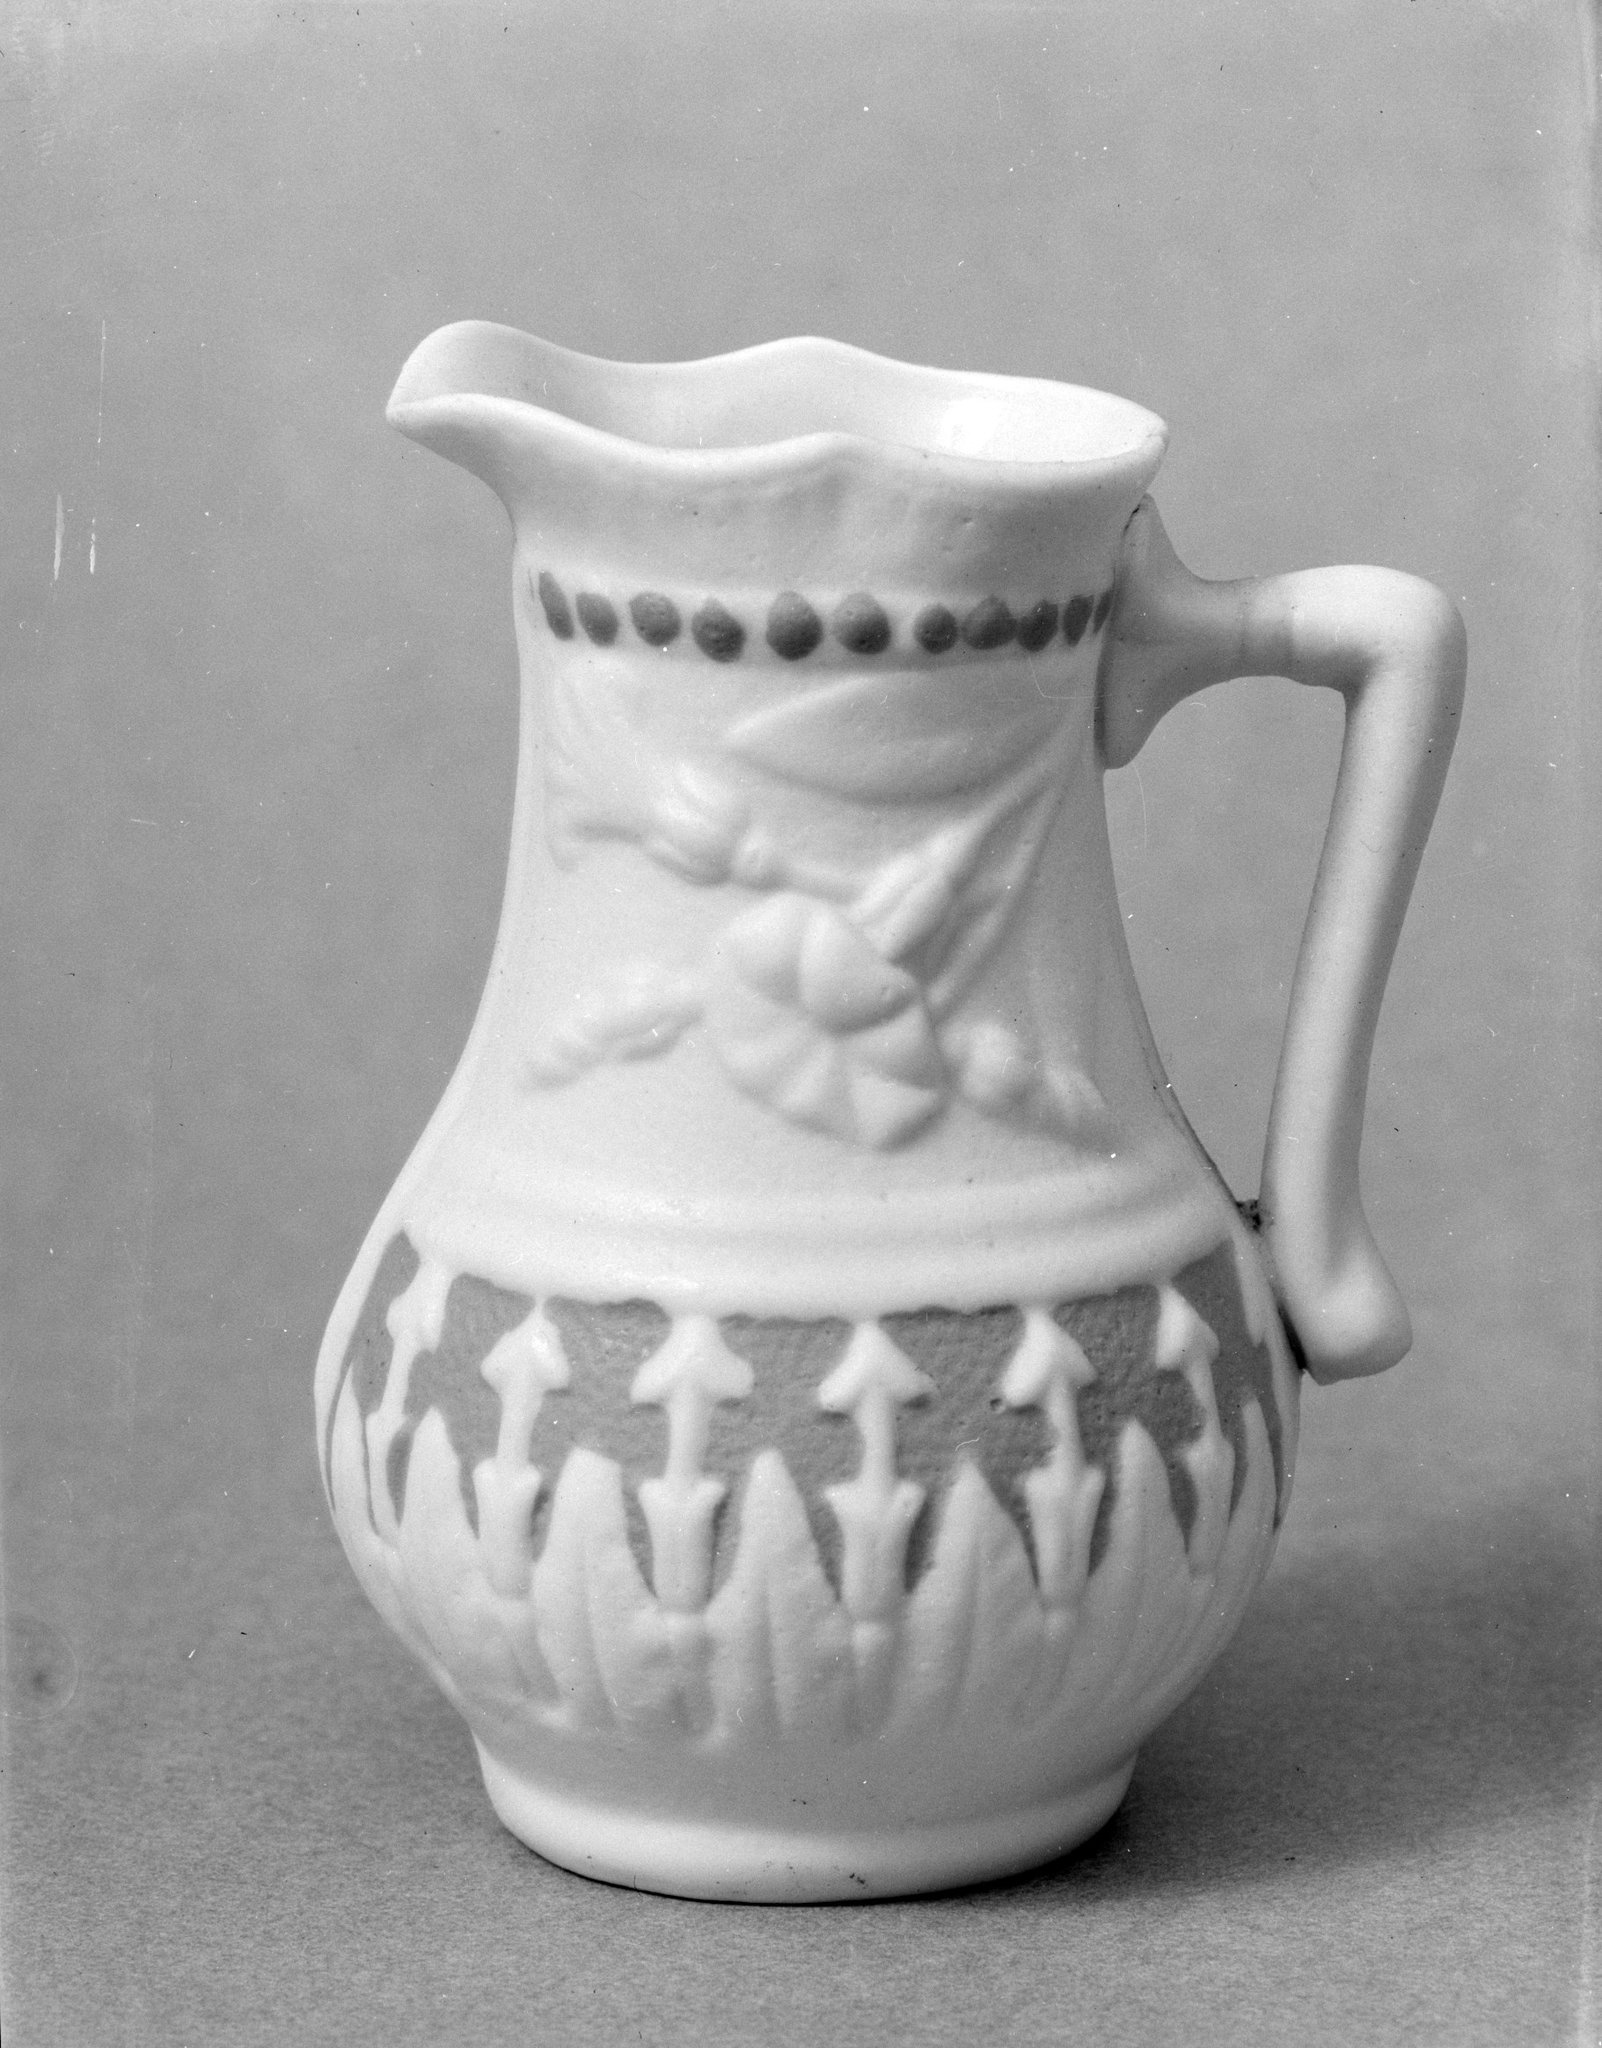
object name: pitcher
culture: american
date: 1830-1870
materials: porcelain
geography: united states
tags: flowers